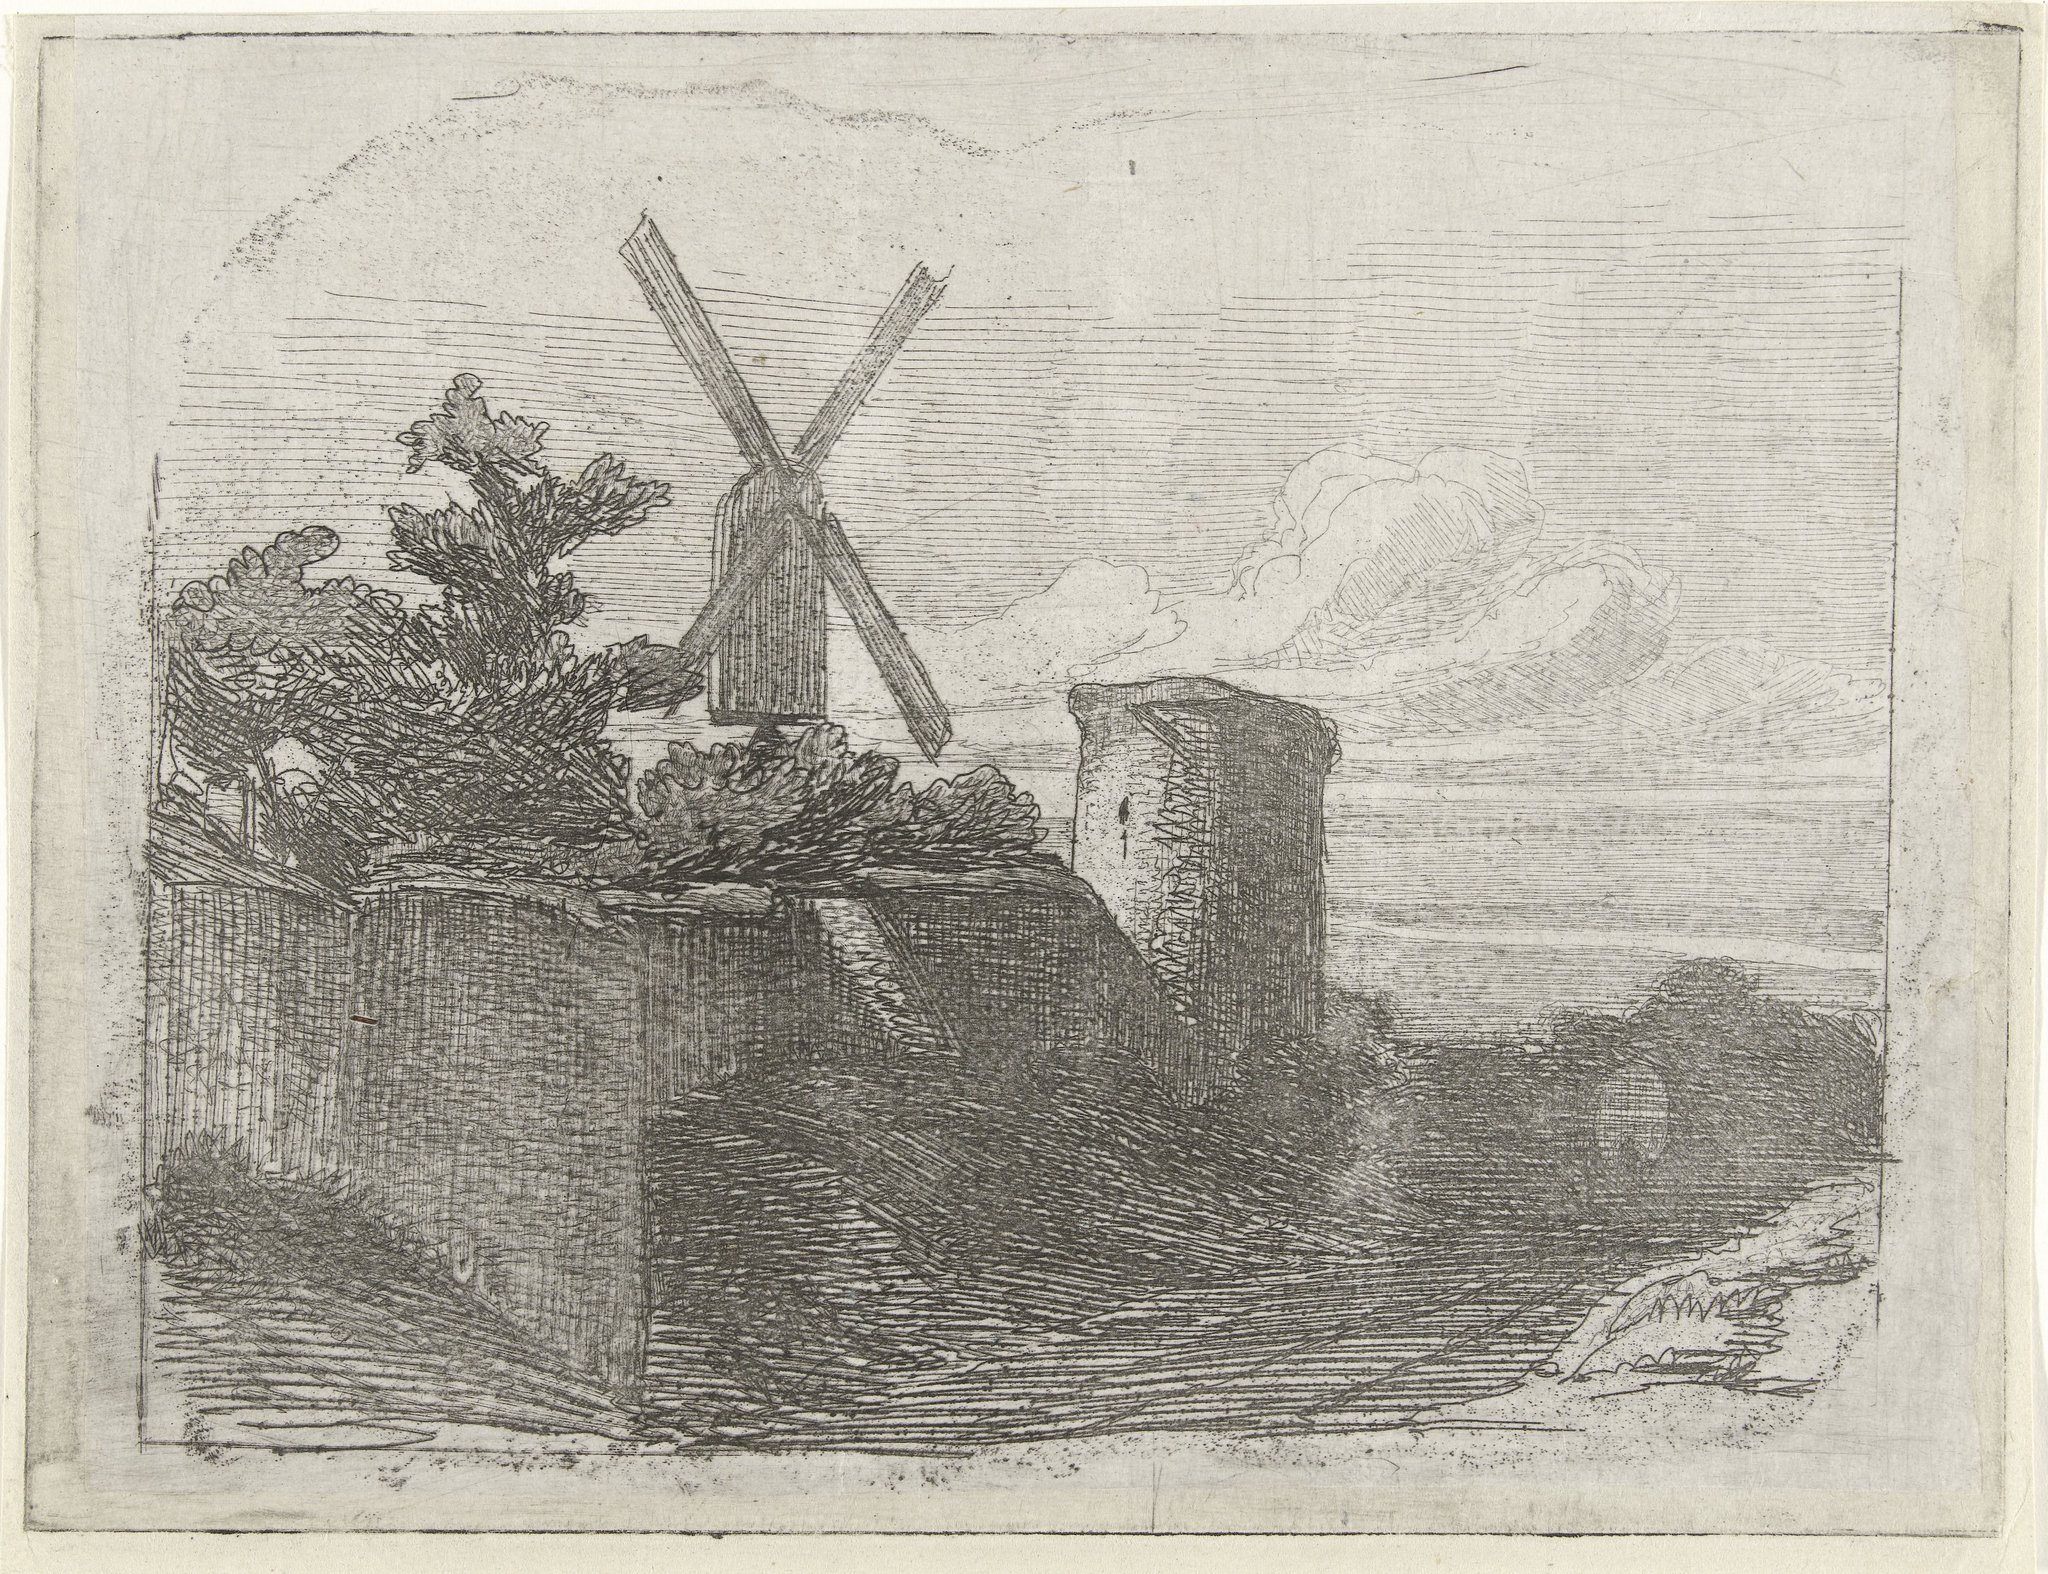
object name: print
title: Ruïne met molen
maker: lambertus hardenberg (1822-1900)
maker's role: draughtsman, painter, print maker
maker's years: 1822-1900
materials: paper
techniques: etching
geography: the hague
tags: landscape with ruins, windmill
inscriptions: collector's mark: Lugt 2228